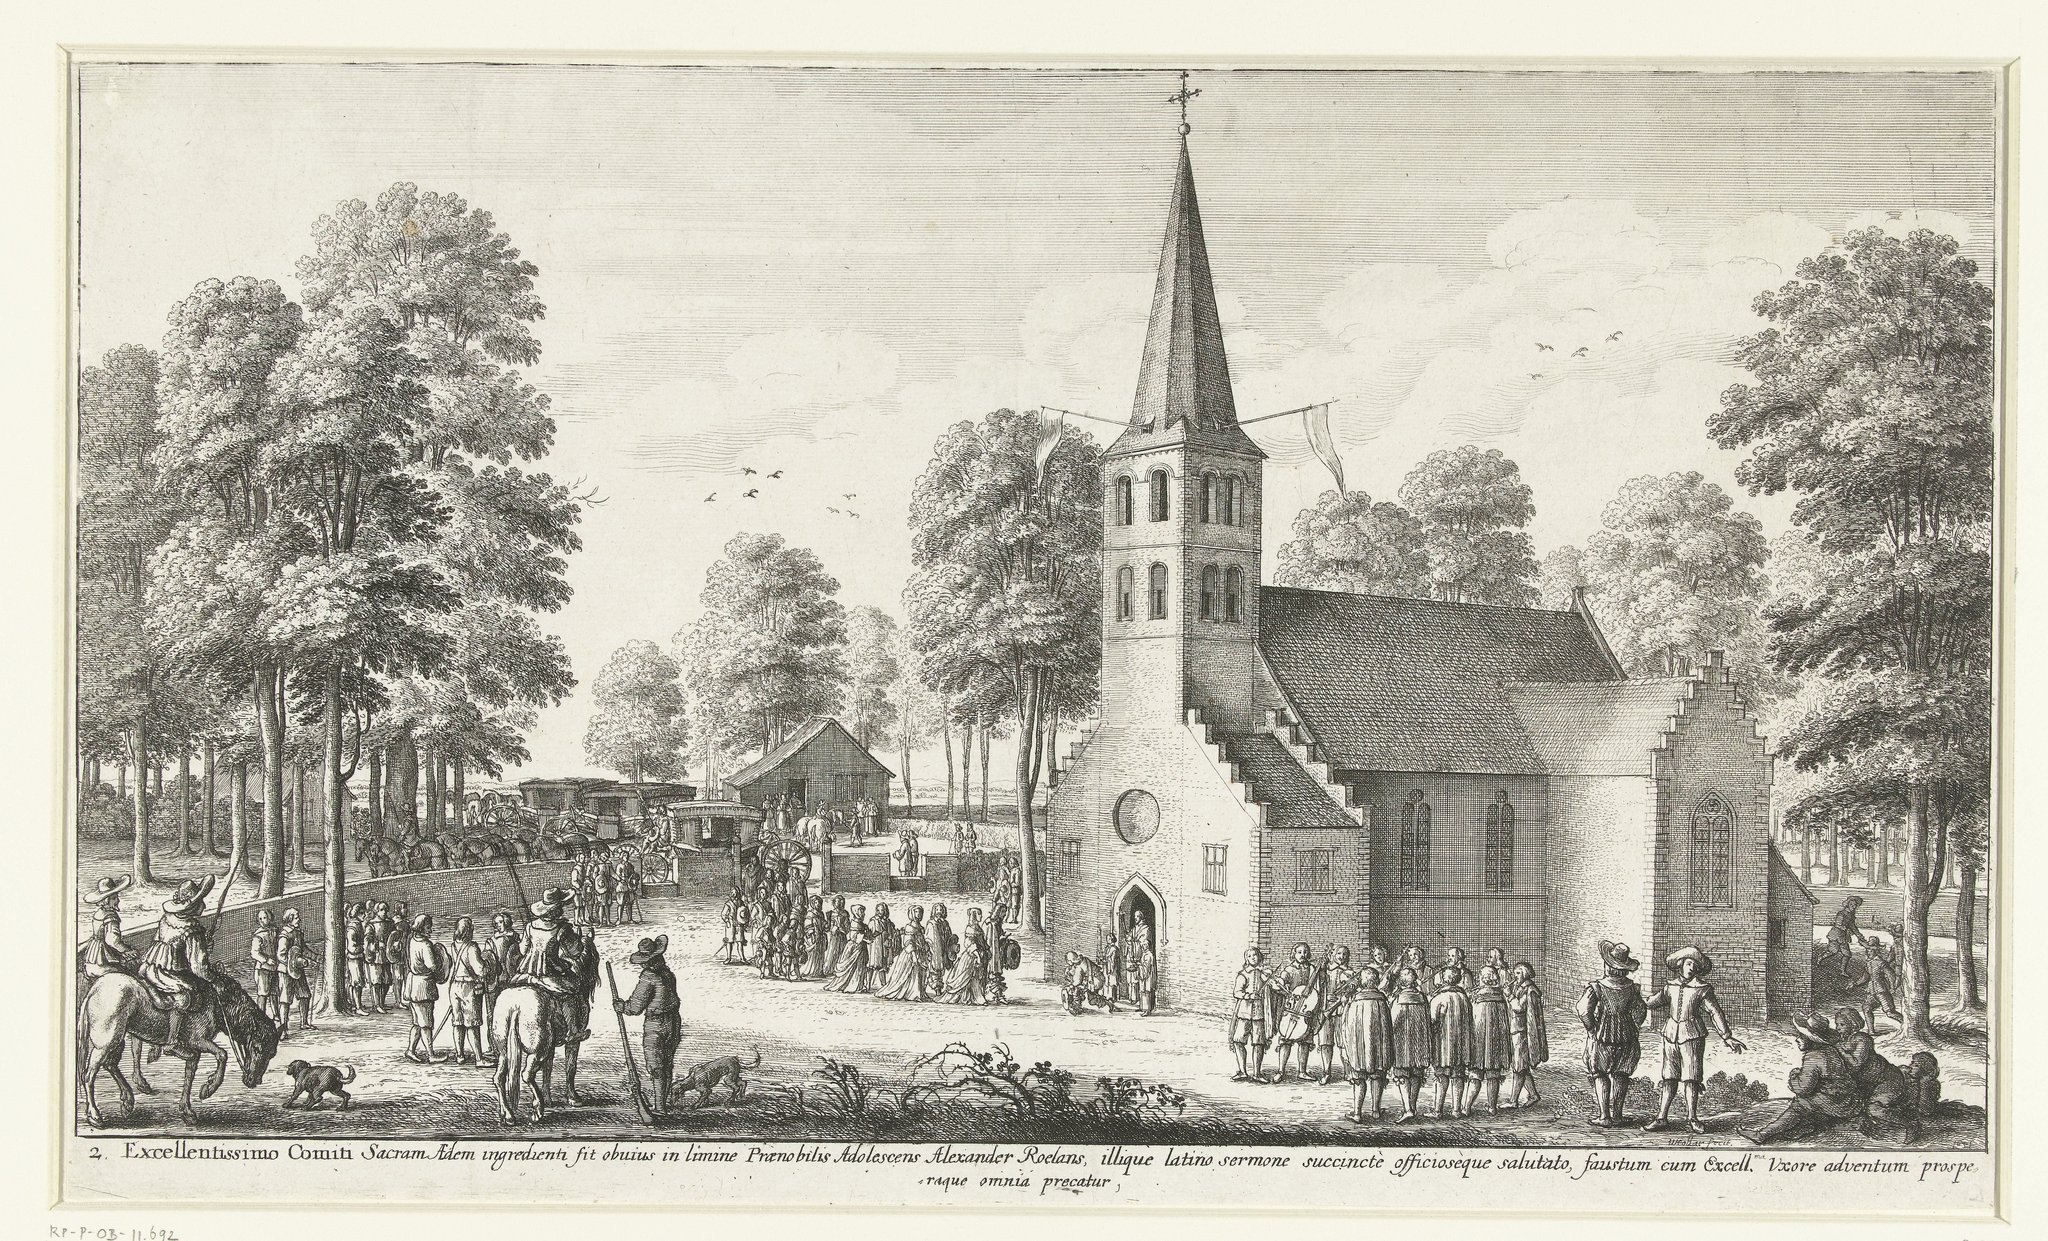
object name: print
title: Het bezoek van graaf Lamoral von Thurn und Taxis aan Alexander Roelants, 1650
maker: wenceslaus hollar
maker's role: draughtsman, print maker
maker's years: 1607-1677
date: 1651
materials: paper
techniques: etching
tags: going to church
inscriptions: date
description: De keizerlijke hoofdpostmeester graaf Lamoral von Thurn und Taxis en zijn vrouw de gravin gaan in Hemiksem ter kerke. Bij de kerk worden ze begroet door keizerlijke postmeester voor de Nederlanden Alexander Roelants, de priester en een orkestje. Genummerd linksonder: 2. Met onderschrift van twee regels in het Latijn.